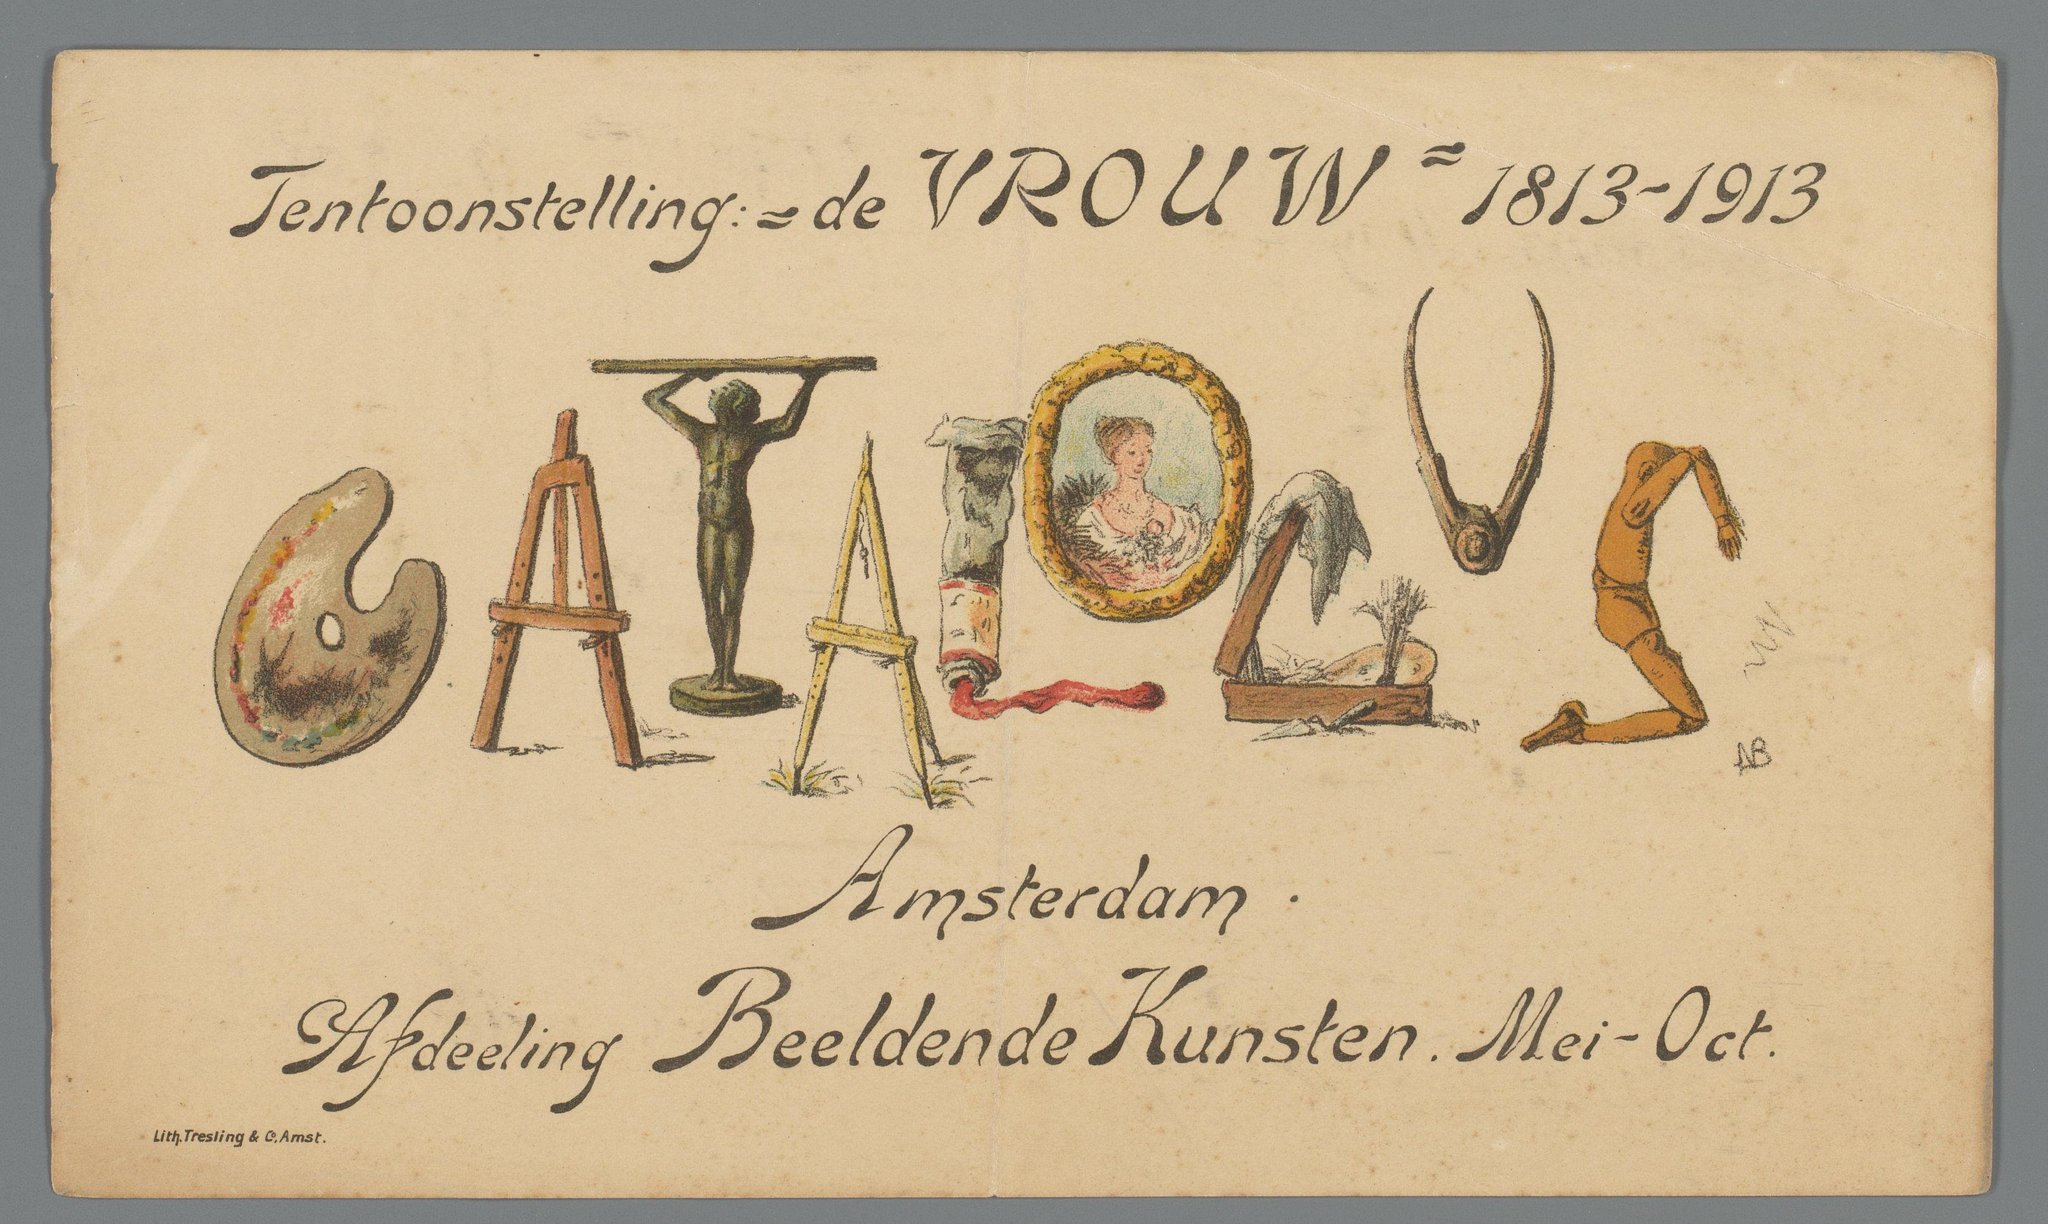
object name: print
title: Voorzijde van het omslag van de catalogus van de tentoonstelling 'De Vrouw 1813-1913'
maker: Anonymous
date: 1905-1913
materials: paper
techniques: lithograph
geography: amsterdam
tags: tools, implements of painter, collection, exhibition, show, amsterdam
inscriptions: inscription: ‘Uit legaat Cornelis Veth 1963’, inscription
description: Diverse schildersbenodigdheden die de letters van het woord 'Catalogus' vormen; onder andere twee ezels, een verftube en een anatomisch model. Met de tekst: 'Tenstoonstelling: 'De Vrouw' 1813-1913. Catalogus. Amsterdam, Afdeeling Beeldende Kunsten, Mei-Oct'.